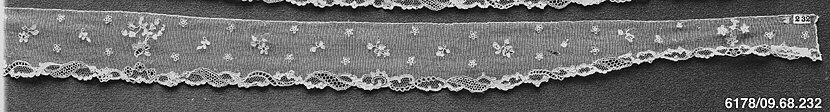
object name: sleeve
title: Sleeve (one of a pair)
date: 1701-1800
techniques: lace